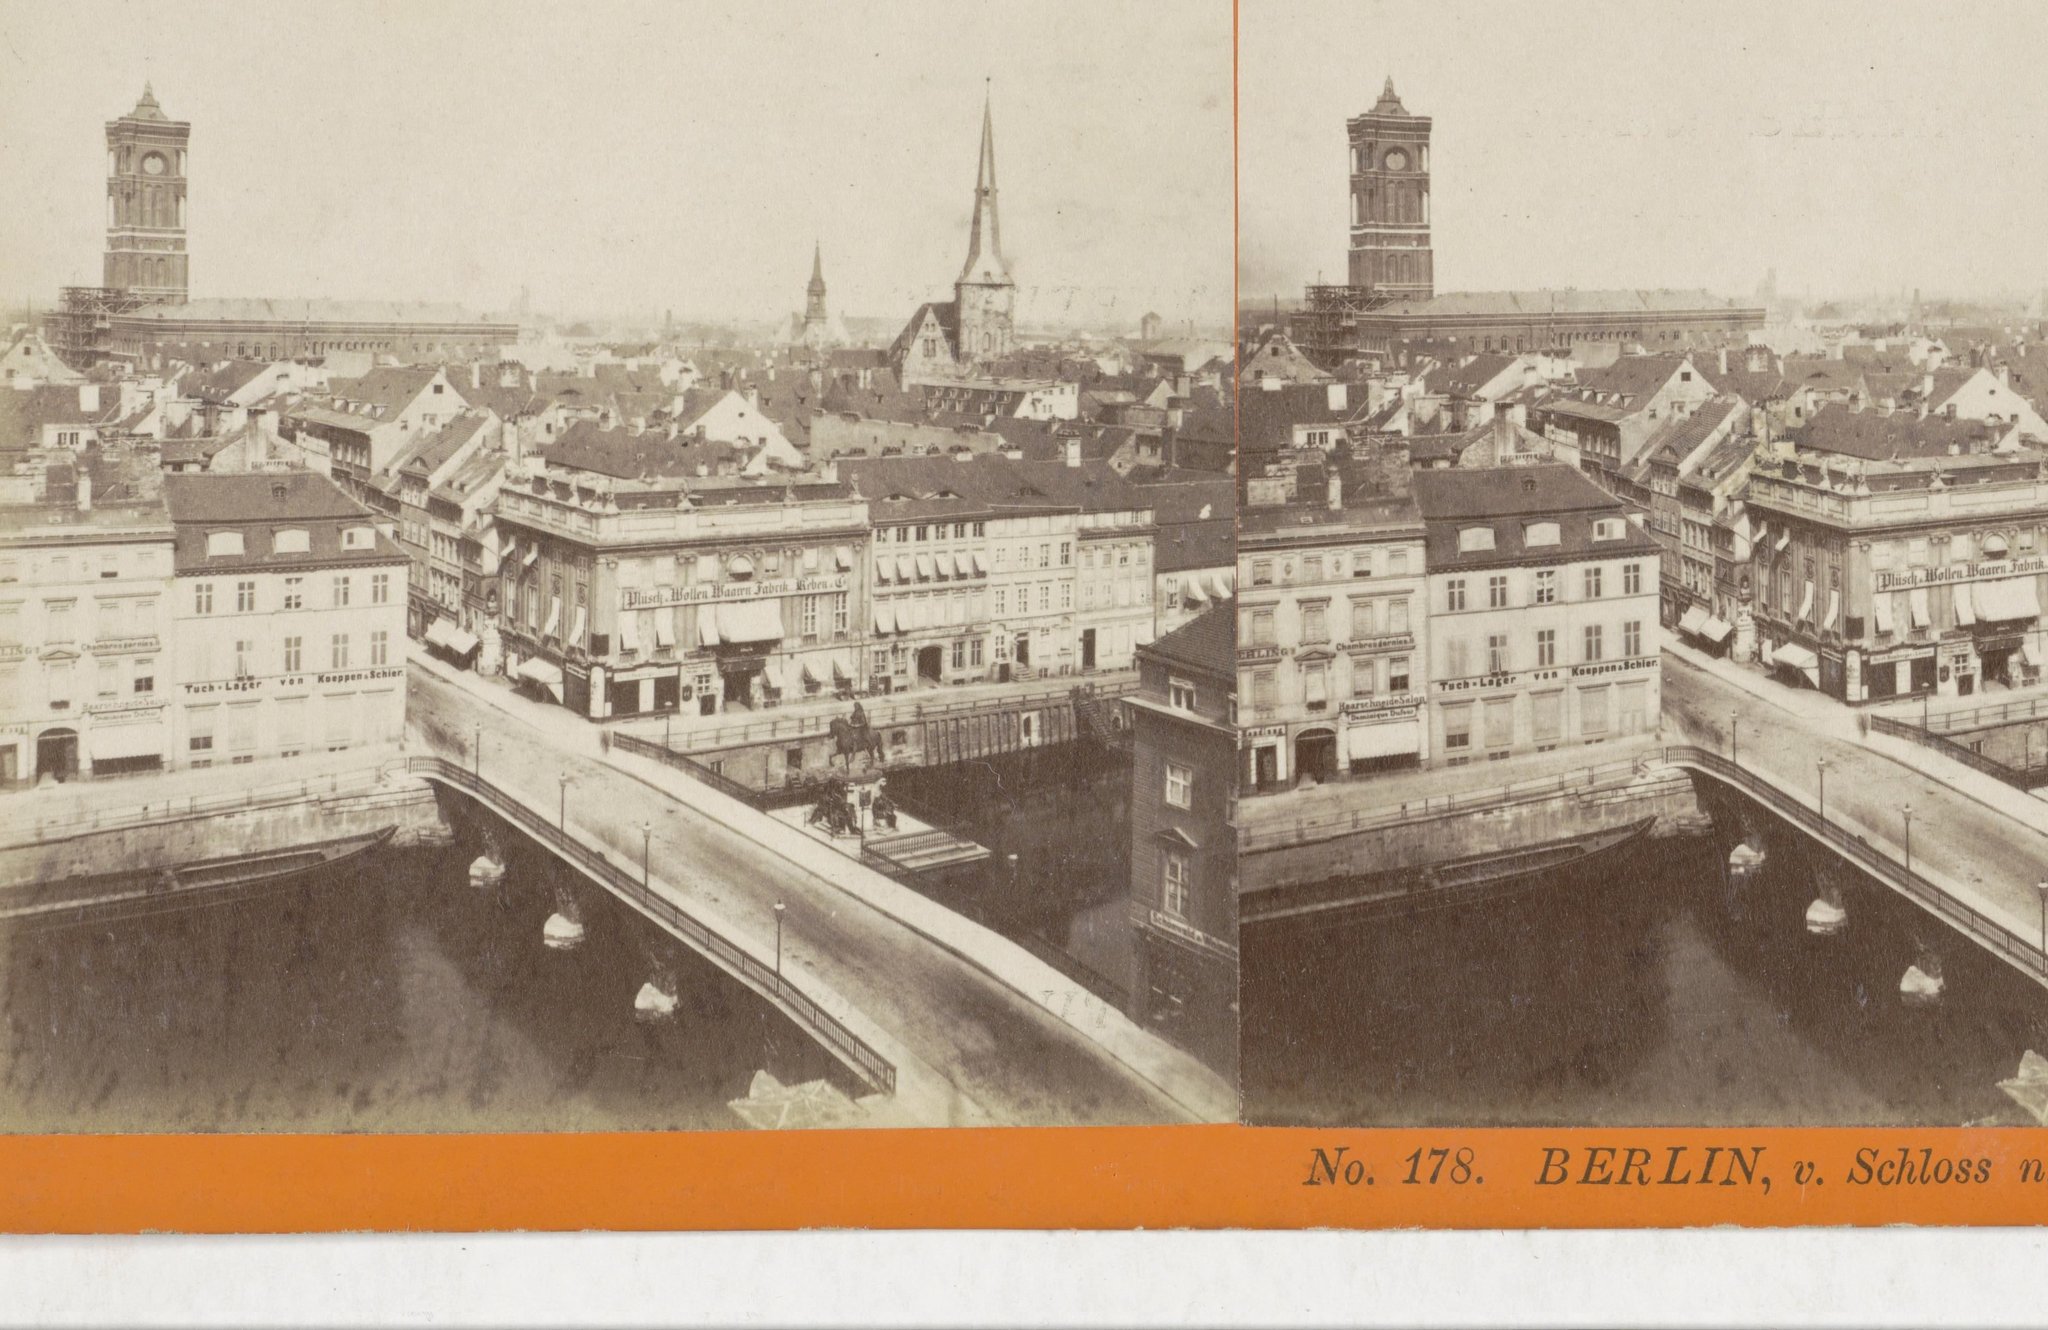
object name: stereograph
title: Ansichten von Deutschland / Berlin und Potsdam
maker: johann friedrich stiehm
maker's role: fotograaf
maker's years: 1826-1902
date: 1868-1870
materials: cardboard, paper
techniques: albumen print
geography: berlin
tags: prospect of city, town panorama, silhouette of city, berlin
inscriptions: number: ‘No. 178.’